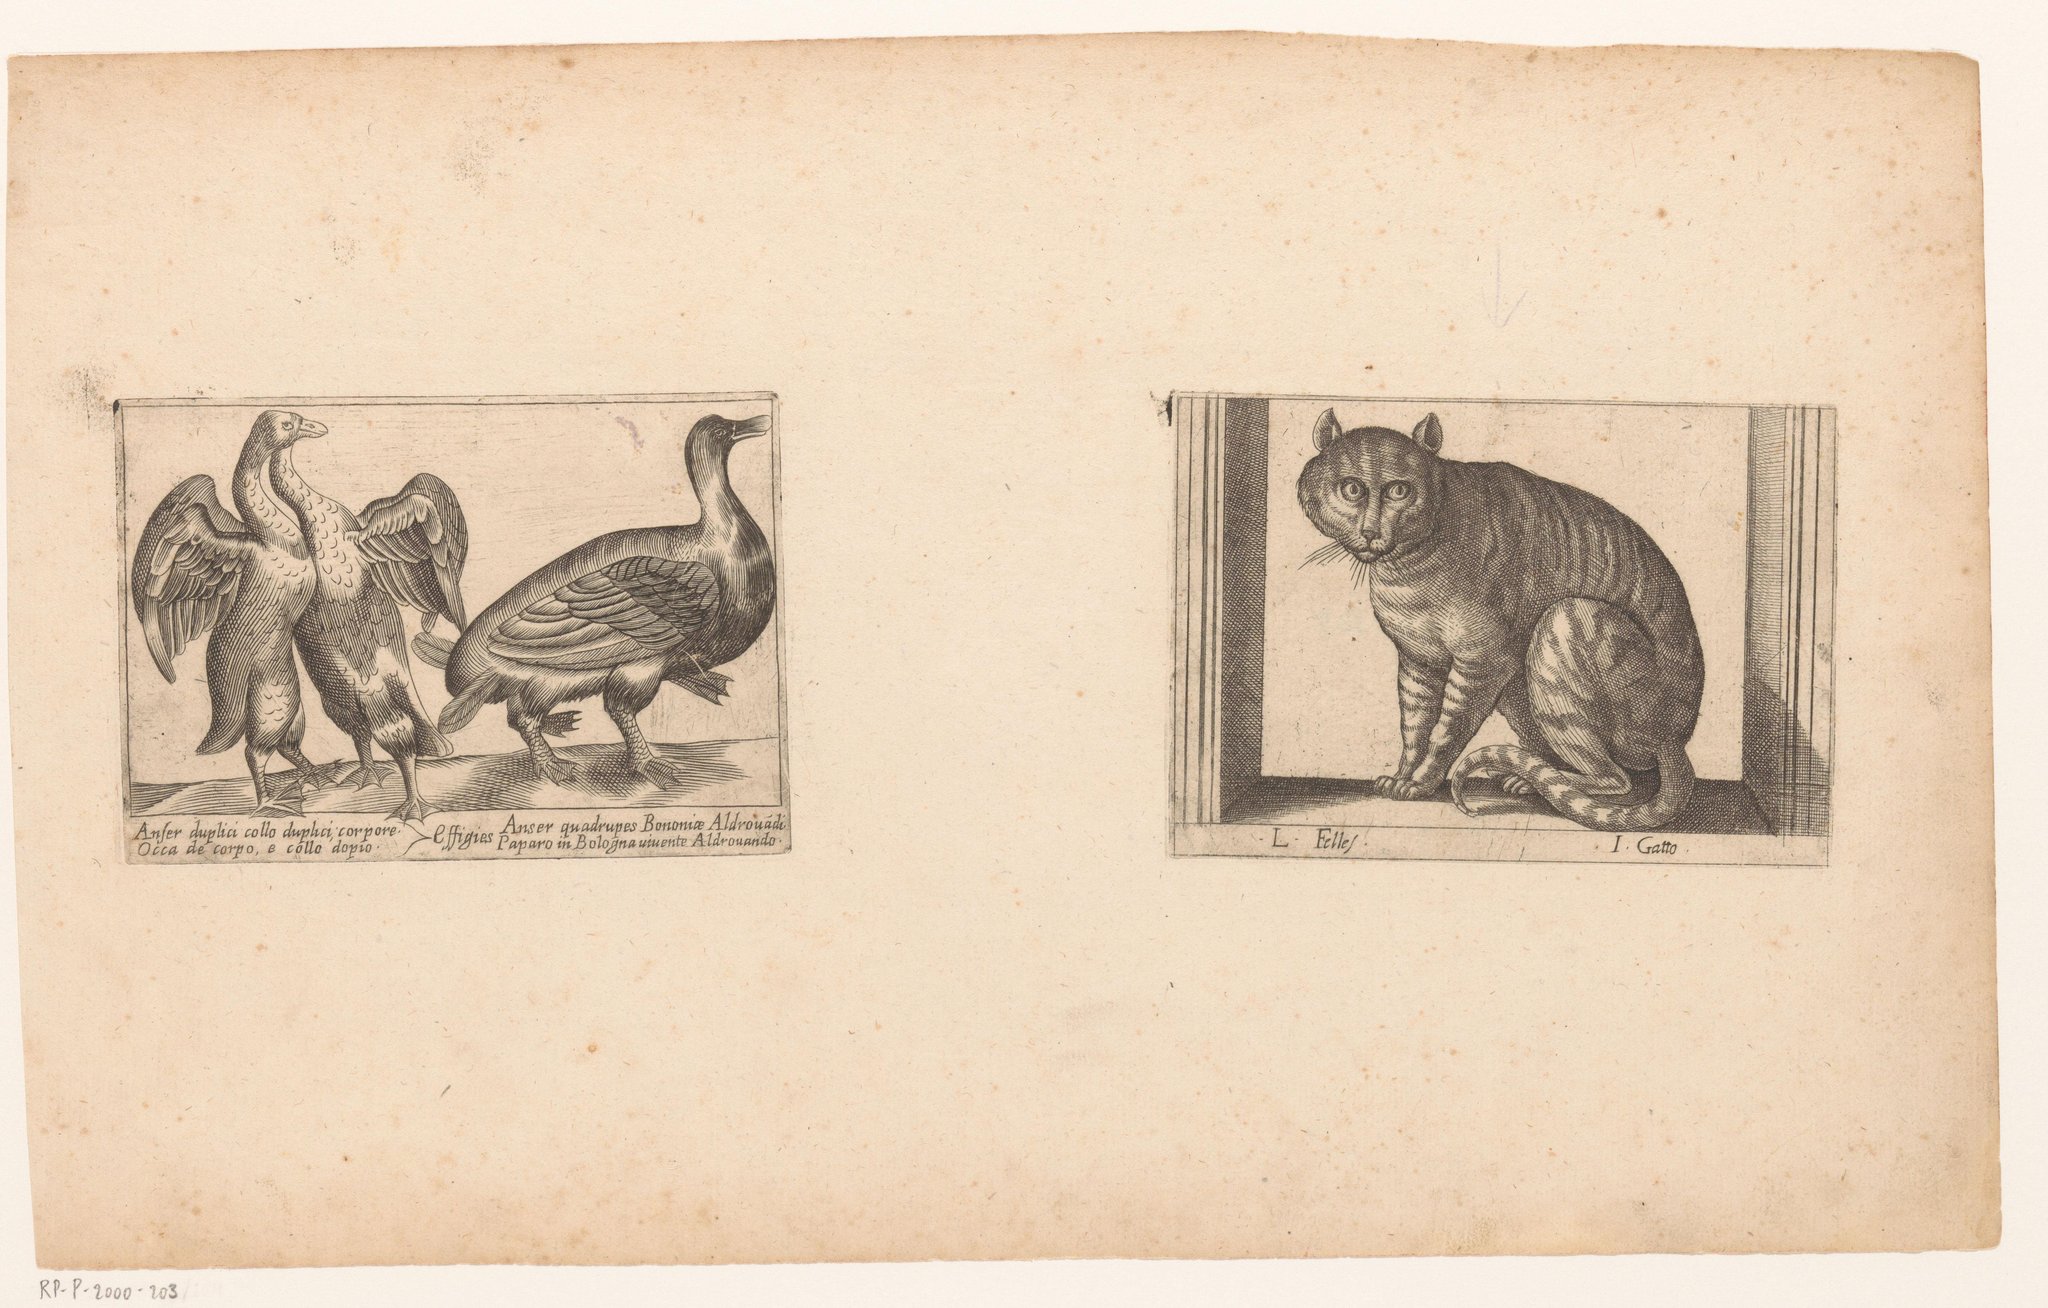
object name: print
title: Nova raccolta de li animali piu curiosi del mondo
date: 1575-1630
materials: paper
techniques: etching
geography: rome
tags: water-birds: goose, cat, mis-shapen animals; monsters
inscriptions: collector's mark: Lugt 2760, collector's mark: Lugt 2228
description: Deze prent maakt deel uit van een reeks prenten van dieren door Antonio Tempesta. Bekend is dat een tweede staat (met nummering) van deze serie is uitgegeven door Giovanni Giacomo de' Rossi in 1650. Onbekend is wie de eerste staat heeft uitgegeven en wanneer.